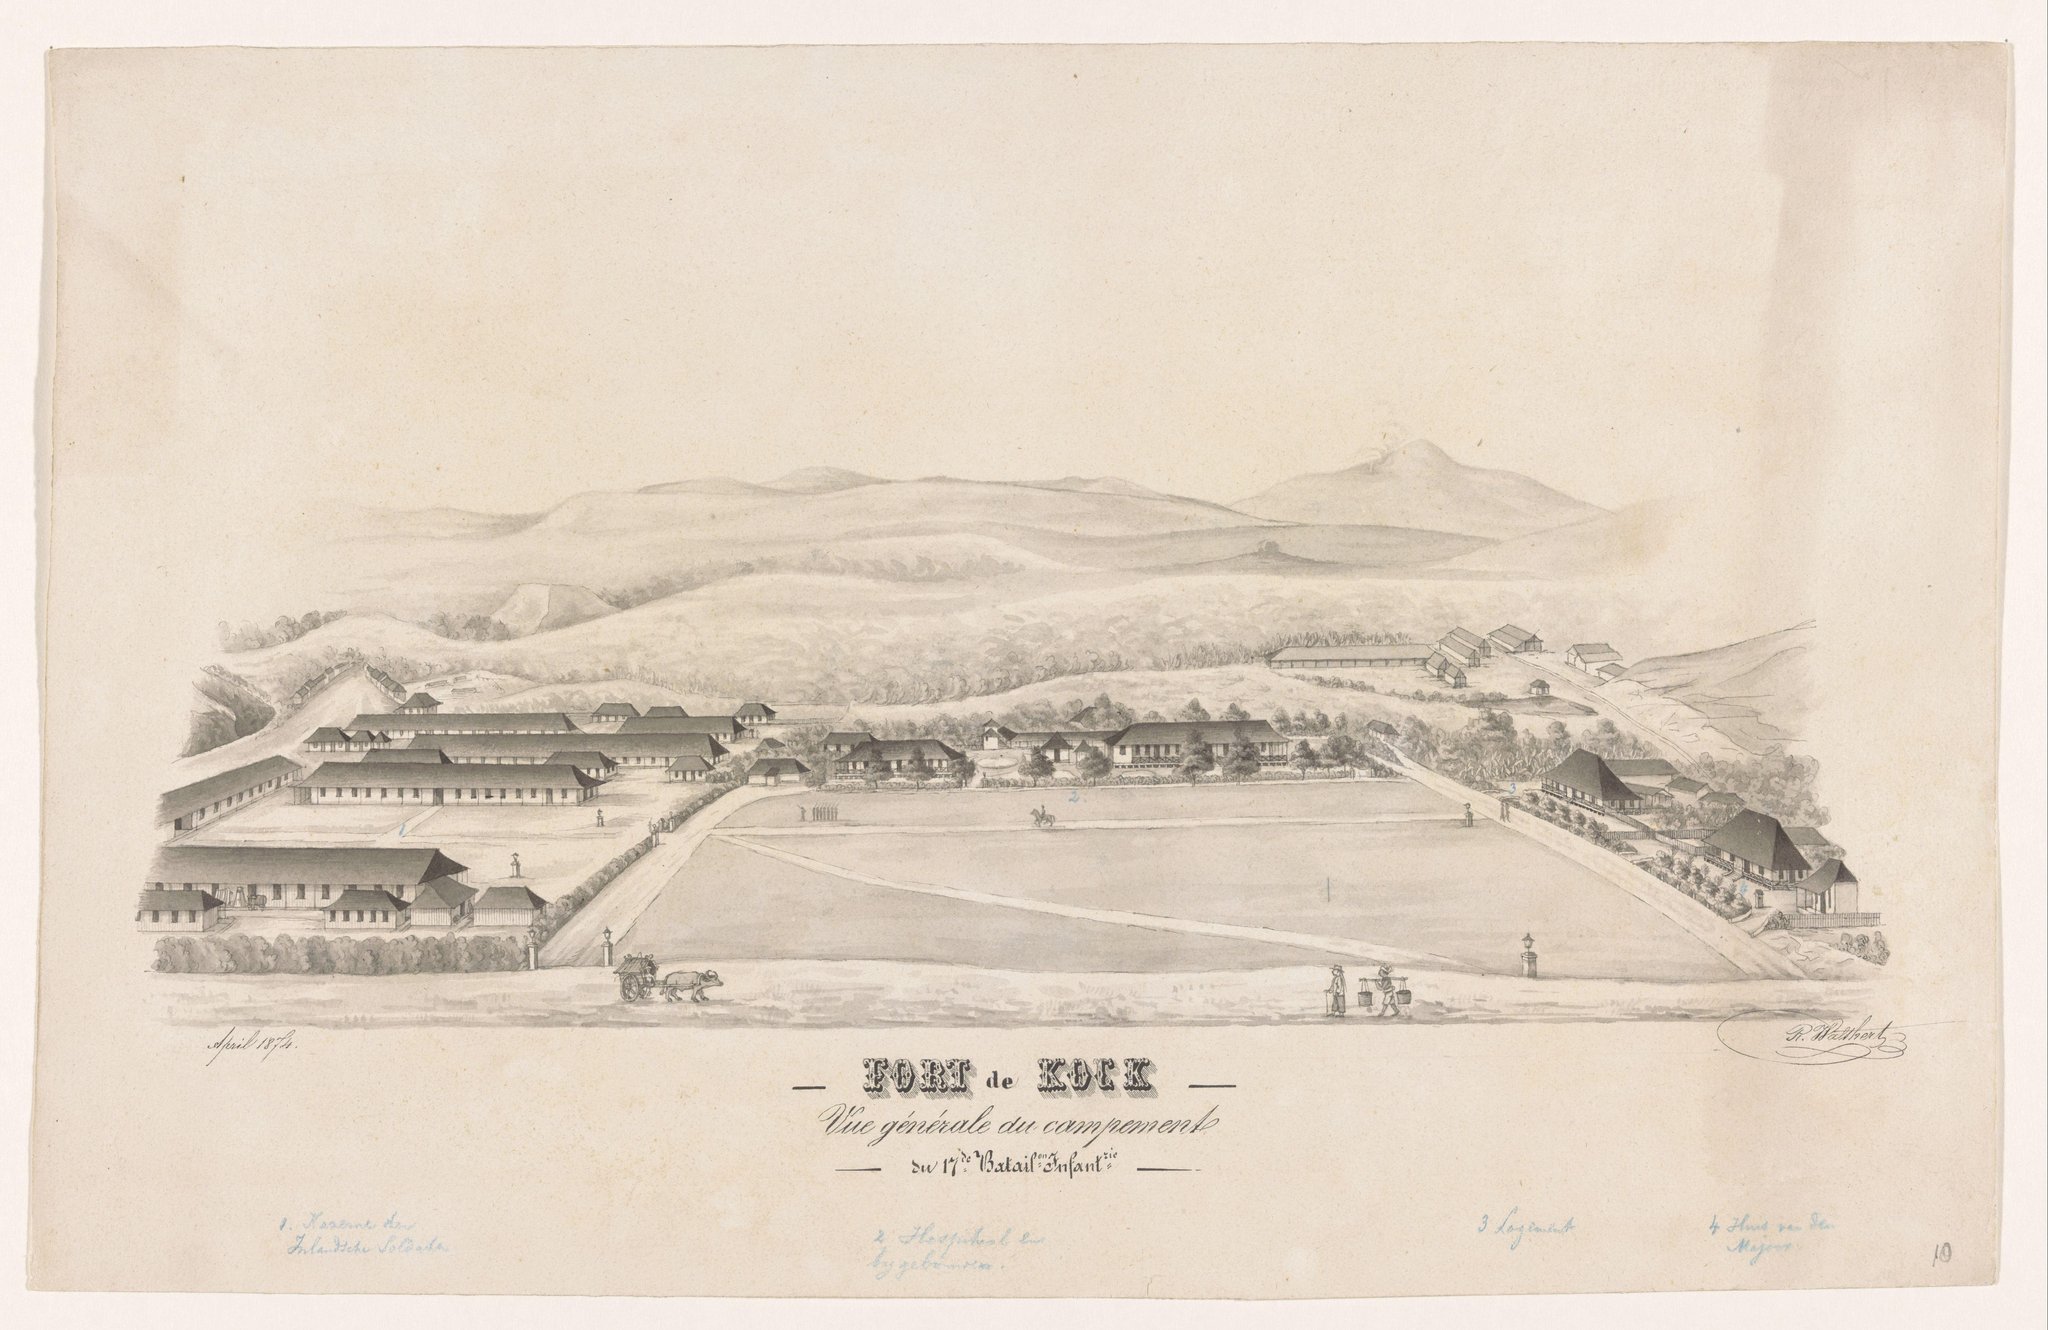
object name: drawing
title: Gezicht op Fort de Kock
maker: r. walthert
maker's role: draughtsman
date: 1804-1874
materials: ink, paper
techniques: brush, pen, writing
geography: sumatra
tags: fortress, sumatra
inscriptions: inscription: ‘1. Kazerne der Inlandse soldaten 2. Hospitaal en bijgebouwen 3. Logement 4. Huis van den majoor’, inscription: ‘FORT de KOCK / Vue générale du campement / du 17de Batailon Infantrie’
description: Heuvellandschap met gezicht op Fort de Kock op Sumatra in april 1874. Legerplaats van het 17e bataljon infanterie. Op een groot, leeg middenterrein excerceren enkele militairen; in het midden een man te paard. Op de voorgrond trekt een karbouw een kar en gaan enkele mannen te voet over een weg. Cijfers geven specifieke gebouwen op het terrein aan.